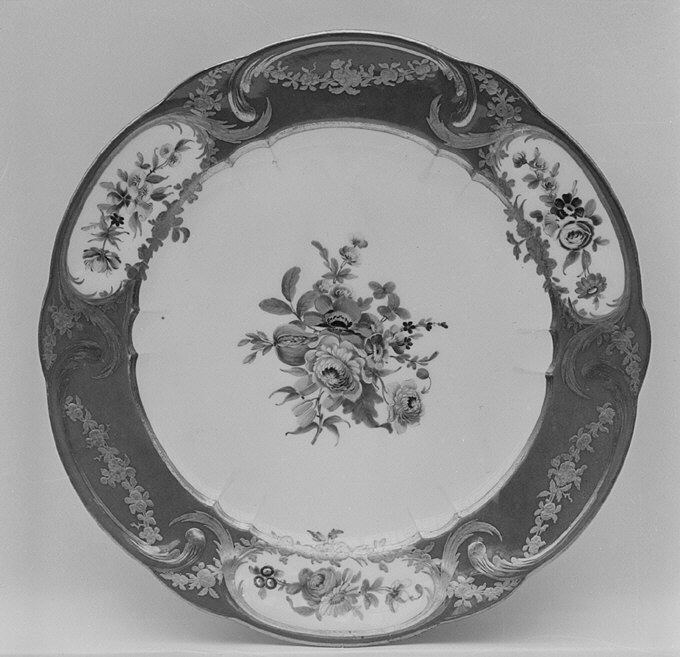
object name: plate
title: Plate (assiette à palmes) (1 of 102) (part of a service)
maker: sèvres manufactory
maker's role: manufactory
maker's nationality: french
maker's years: 1740-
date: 1780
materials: soft paste porcelain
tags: flowers